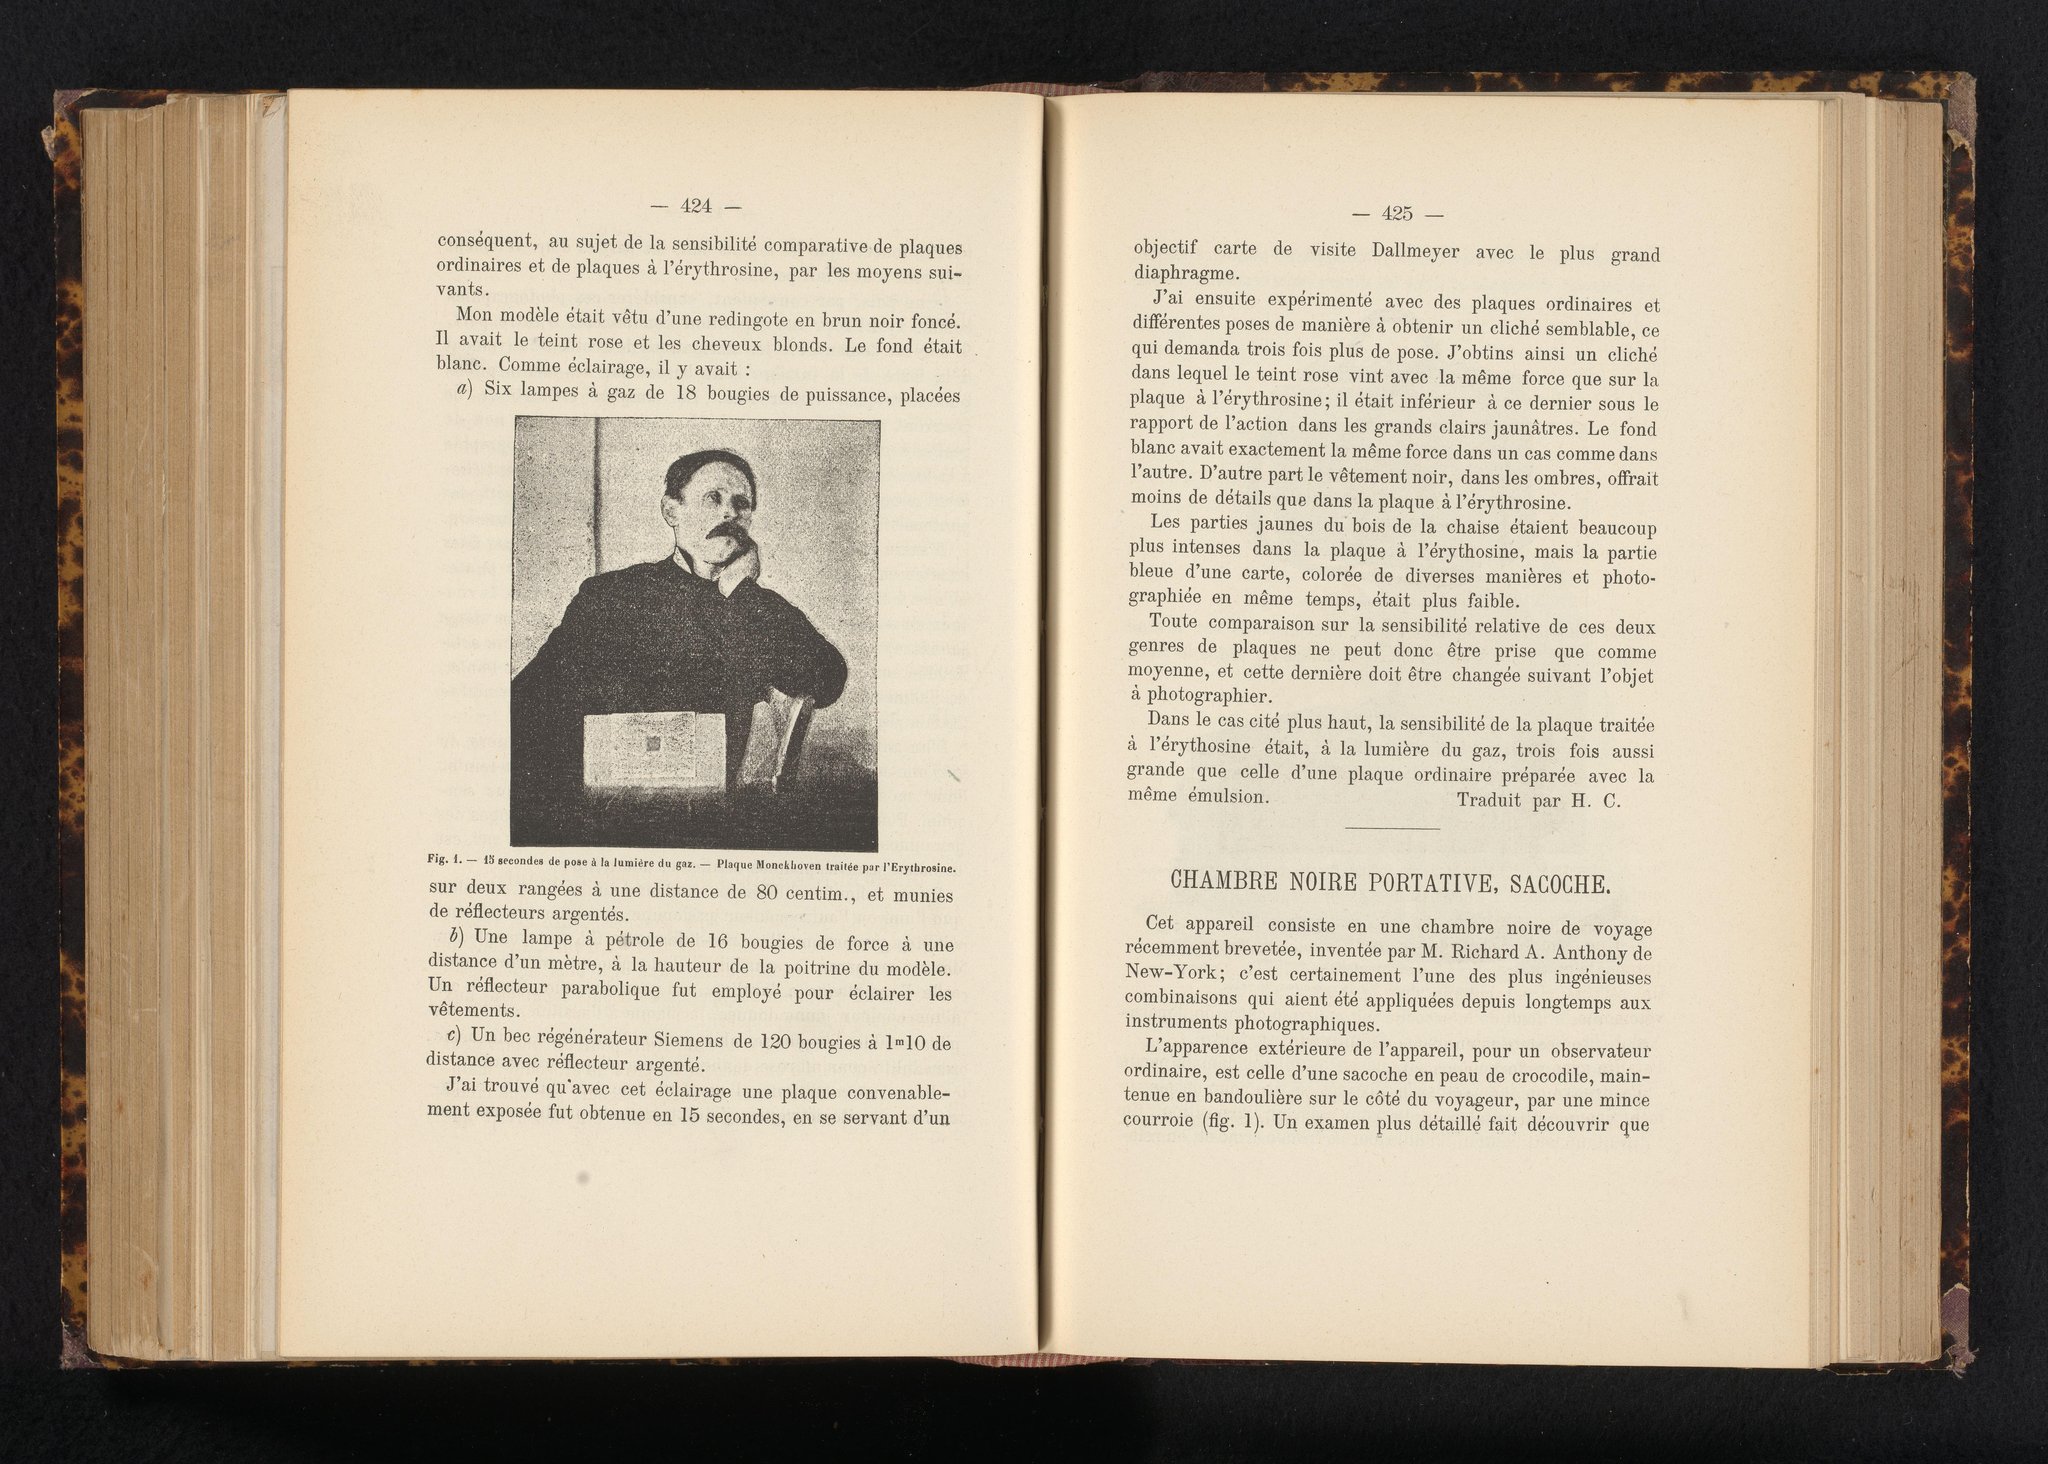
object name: photomechanical print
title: Portret van een onbekende man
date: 1881-1886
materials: paper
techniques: autotype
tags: historical persons not known by name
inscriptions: inscription: ‘Fig. 1.- 15 secondes de pose à la lumière du gaz.- Plaque Monckhoven traitée par l'Erythrosine.’